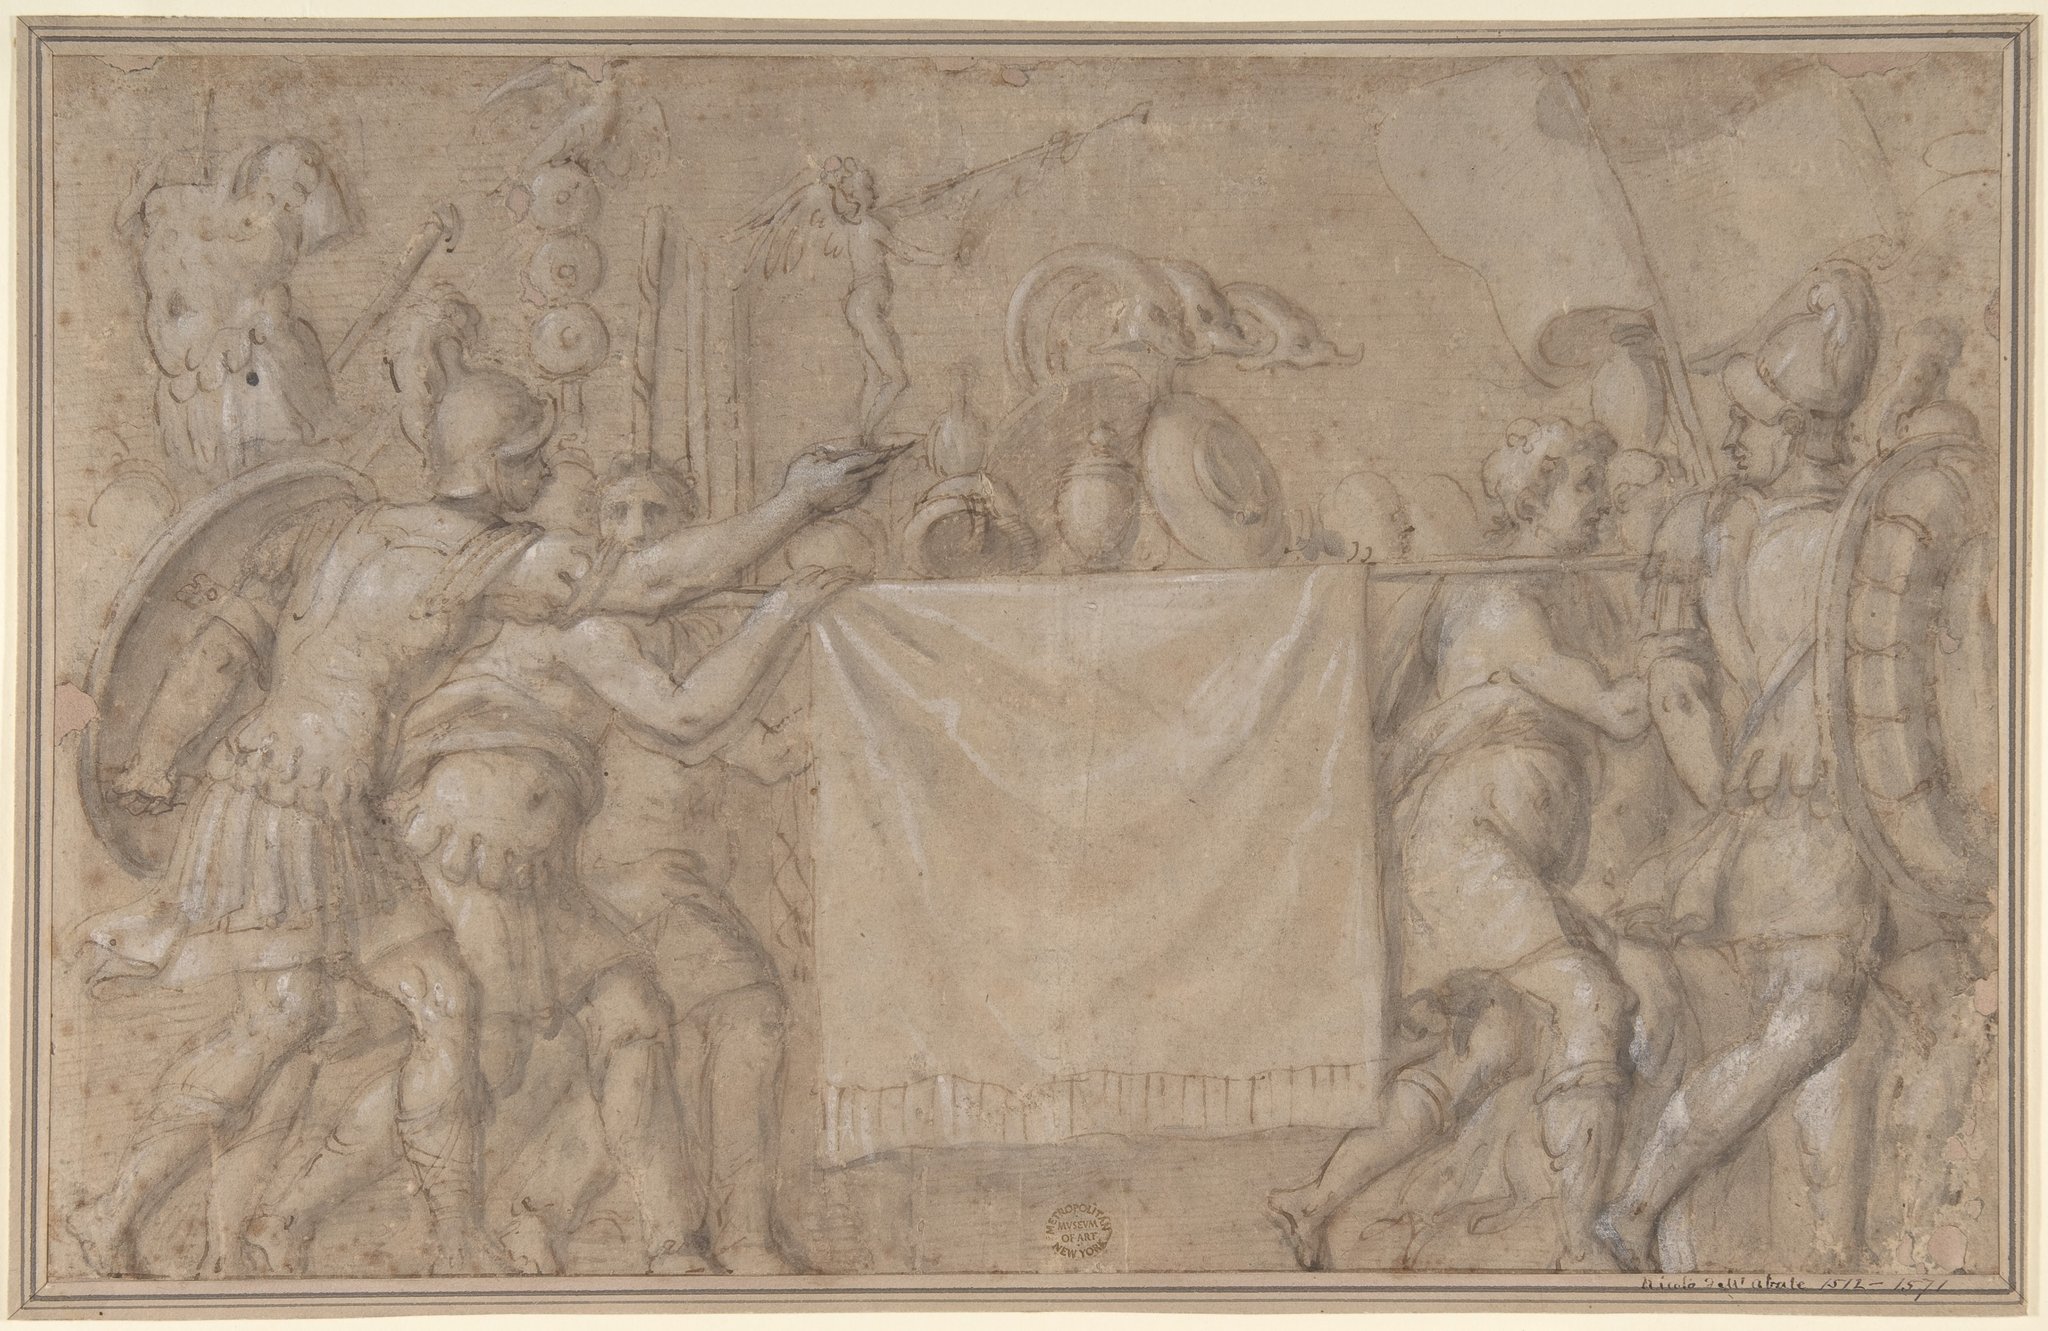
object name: drawing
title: A Roman Triumph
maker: anonymous, italian, 16th century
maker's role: artist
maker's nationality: italian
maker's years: 1550-1600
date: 1501-1600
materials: ink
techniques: brush, heightening, pen, wash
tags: soldiers,men,victory